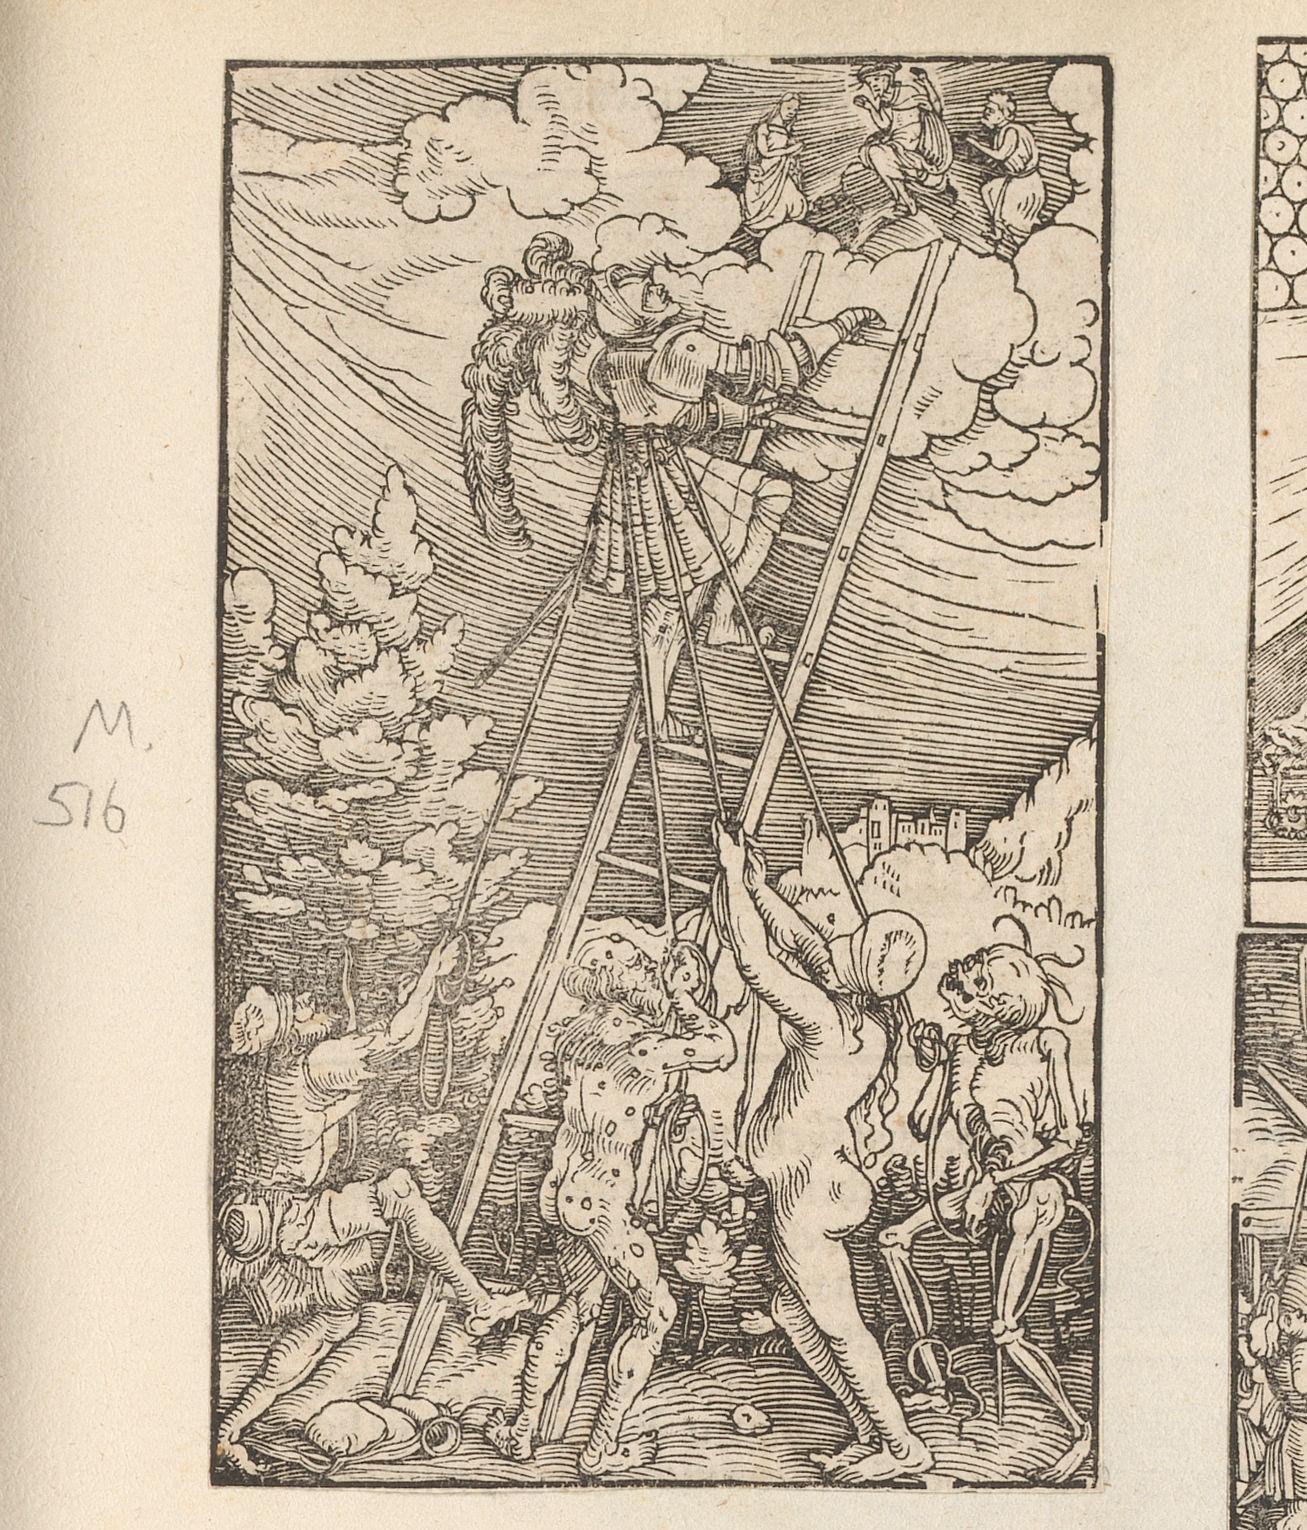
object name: print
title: Ridder beklimt een ladder naar de hemel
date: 1514-1531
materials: paper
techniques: letterpress printing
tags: mis-shapen animals; monsters, knight, ladder, stairway to heaven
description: Deze prent is gebruikt in: Cicero, Marcus Tulius. Officia M.T.C. Ein Buch so Marcus Tullius Cicero der Römer zu seynem (...). [Vertaald uit het Latijn door] Johann von Schwarzenberg. Augsburg: Heinrich Steiner, 1531.